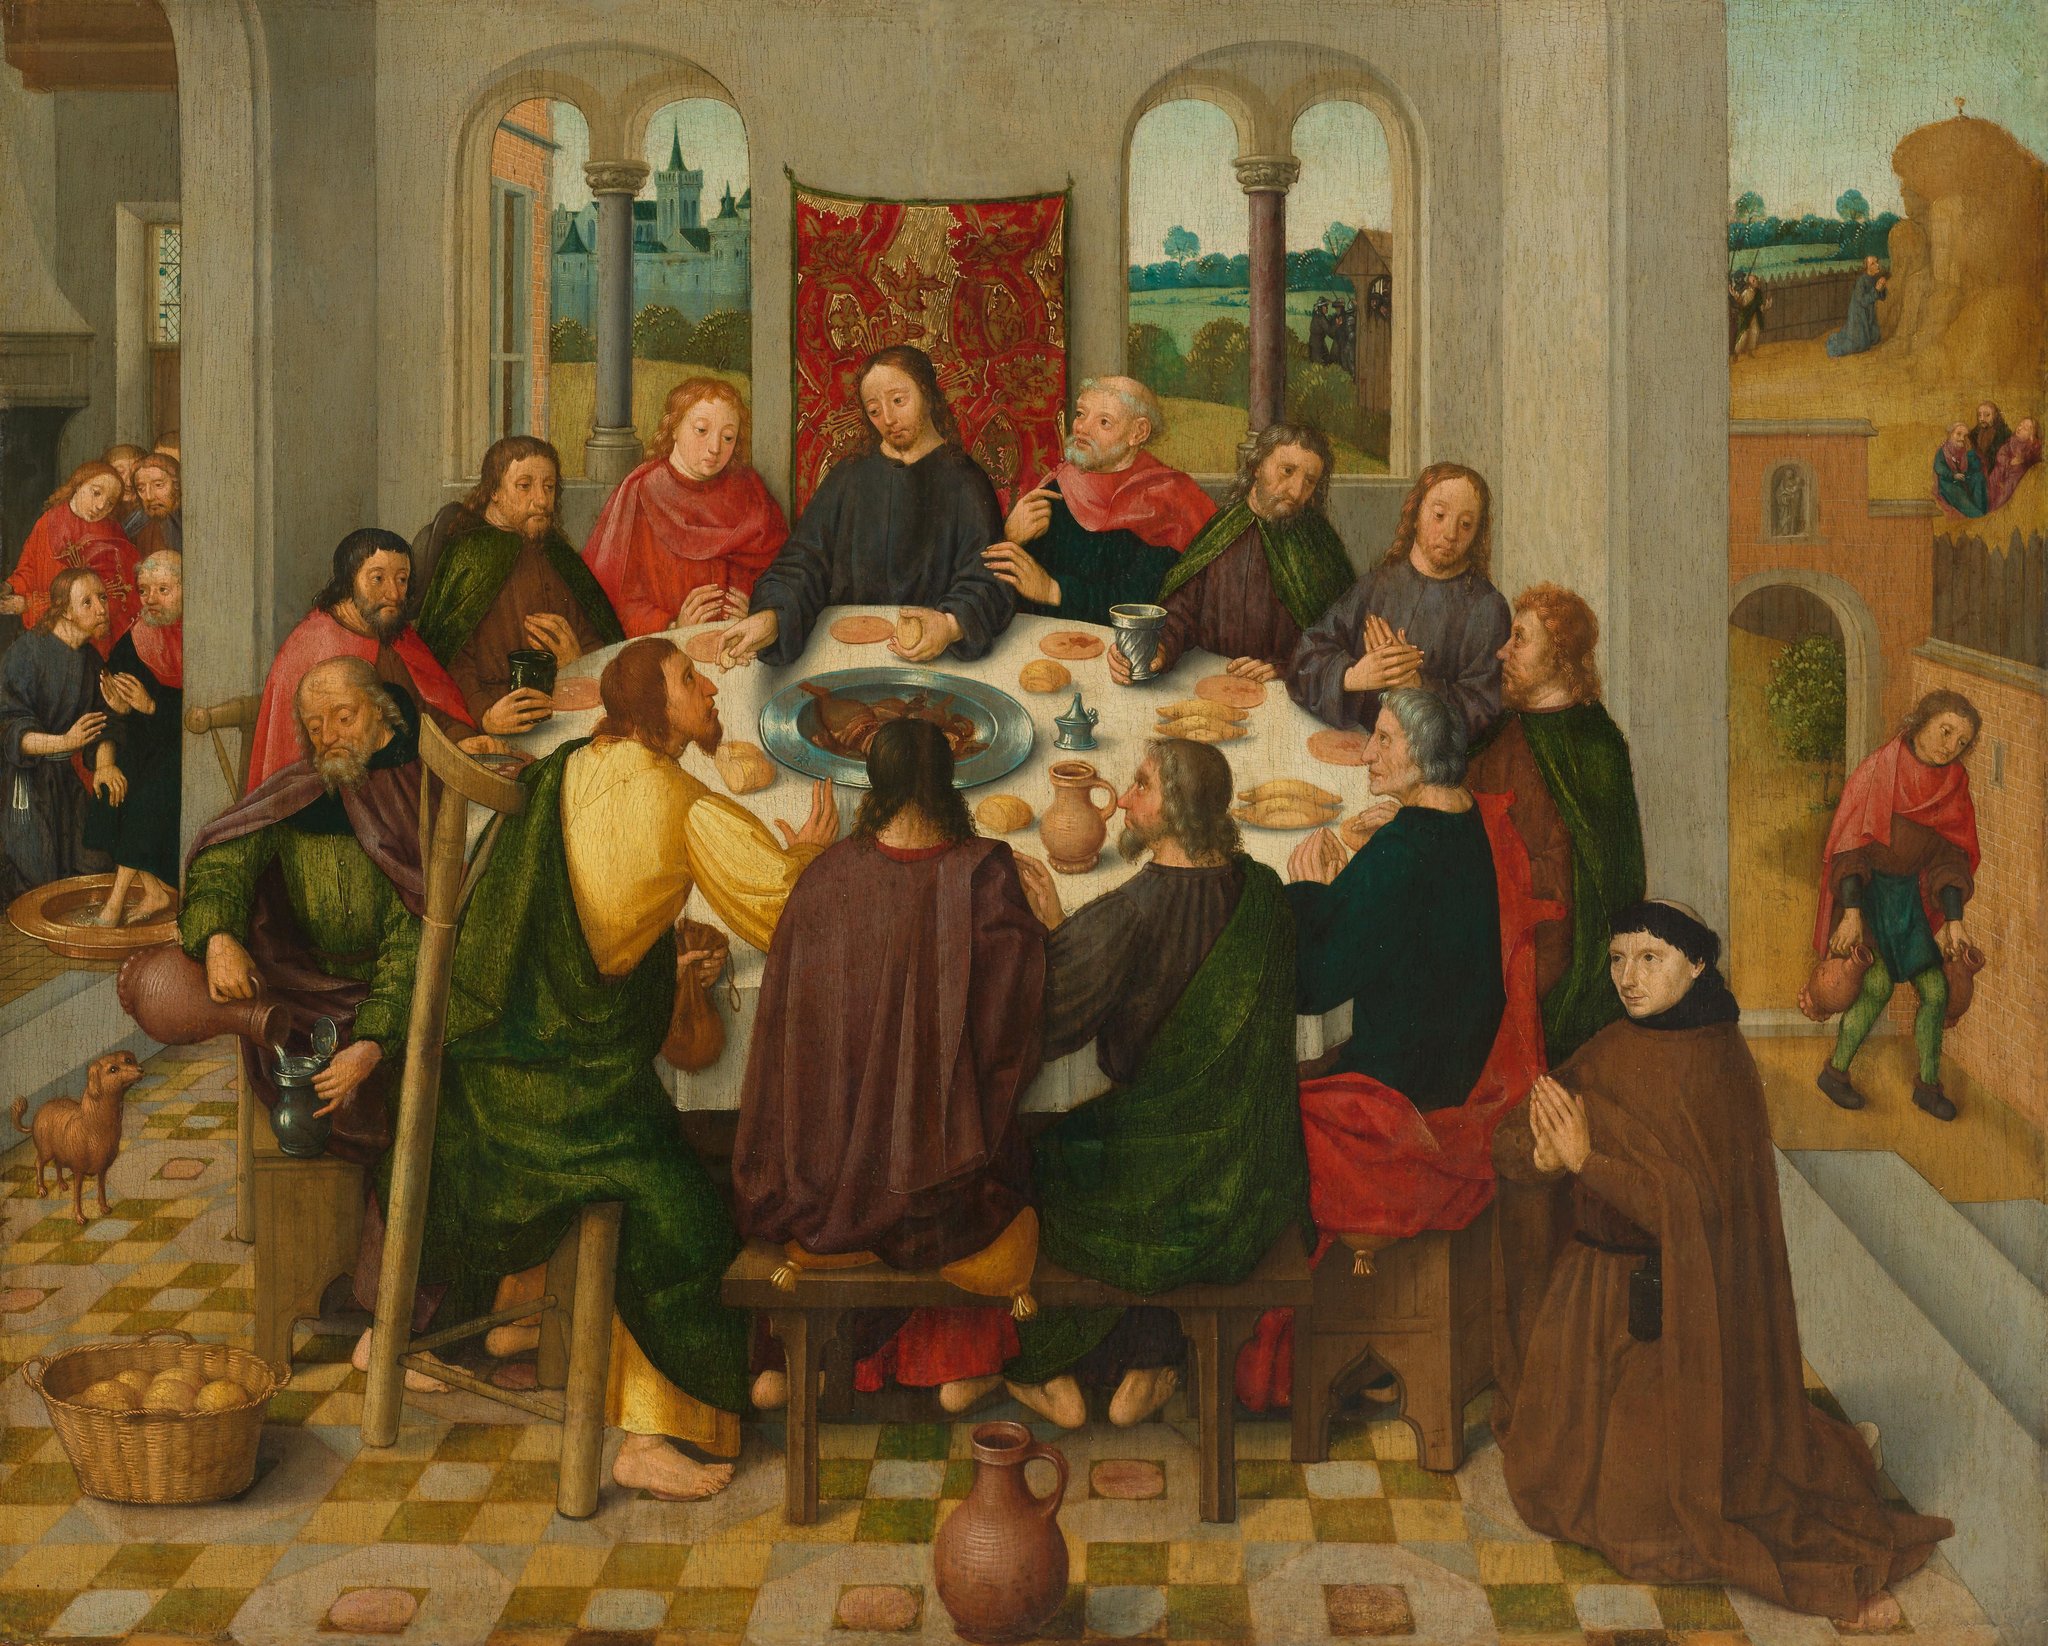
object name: zijpaneel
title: Last Supper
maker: master of the amsterdam death of the virgin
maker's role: painter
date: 1485-1500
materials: oil, panel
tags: last supper (in general) (matthew 26:21-35; mark 14:18-31; luke 22:3, 22:15-23; john 13:21-38)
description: Het laatste avondmaal. In een interieur zit Christus samen met zijn discipelen aan een maaltijd rond een tafel. Rechts op de voorgrond een knielende stichter. In een zijvertrek links is de voetwassing voorgesteld. Rechts op de achtergrond bidt Christus in Gethsemane. Samen met SK-A-2130 de panelen van een altaarstuk.